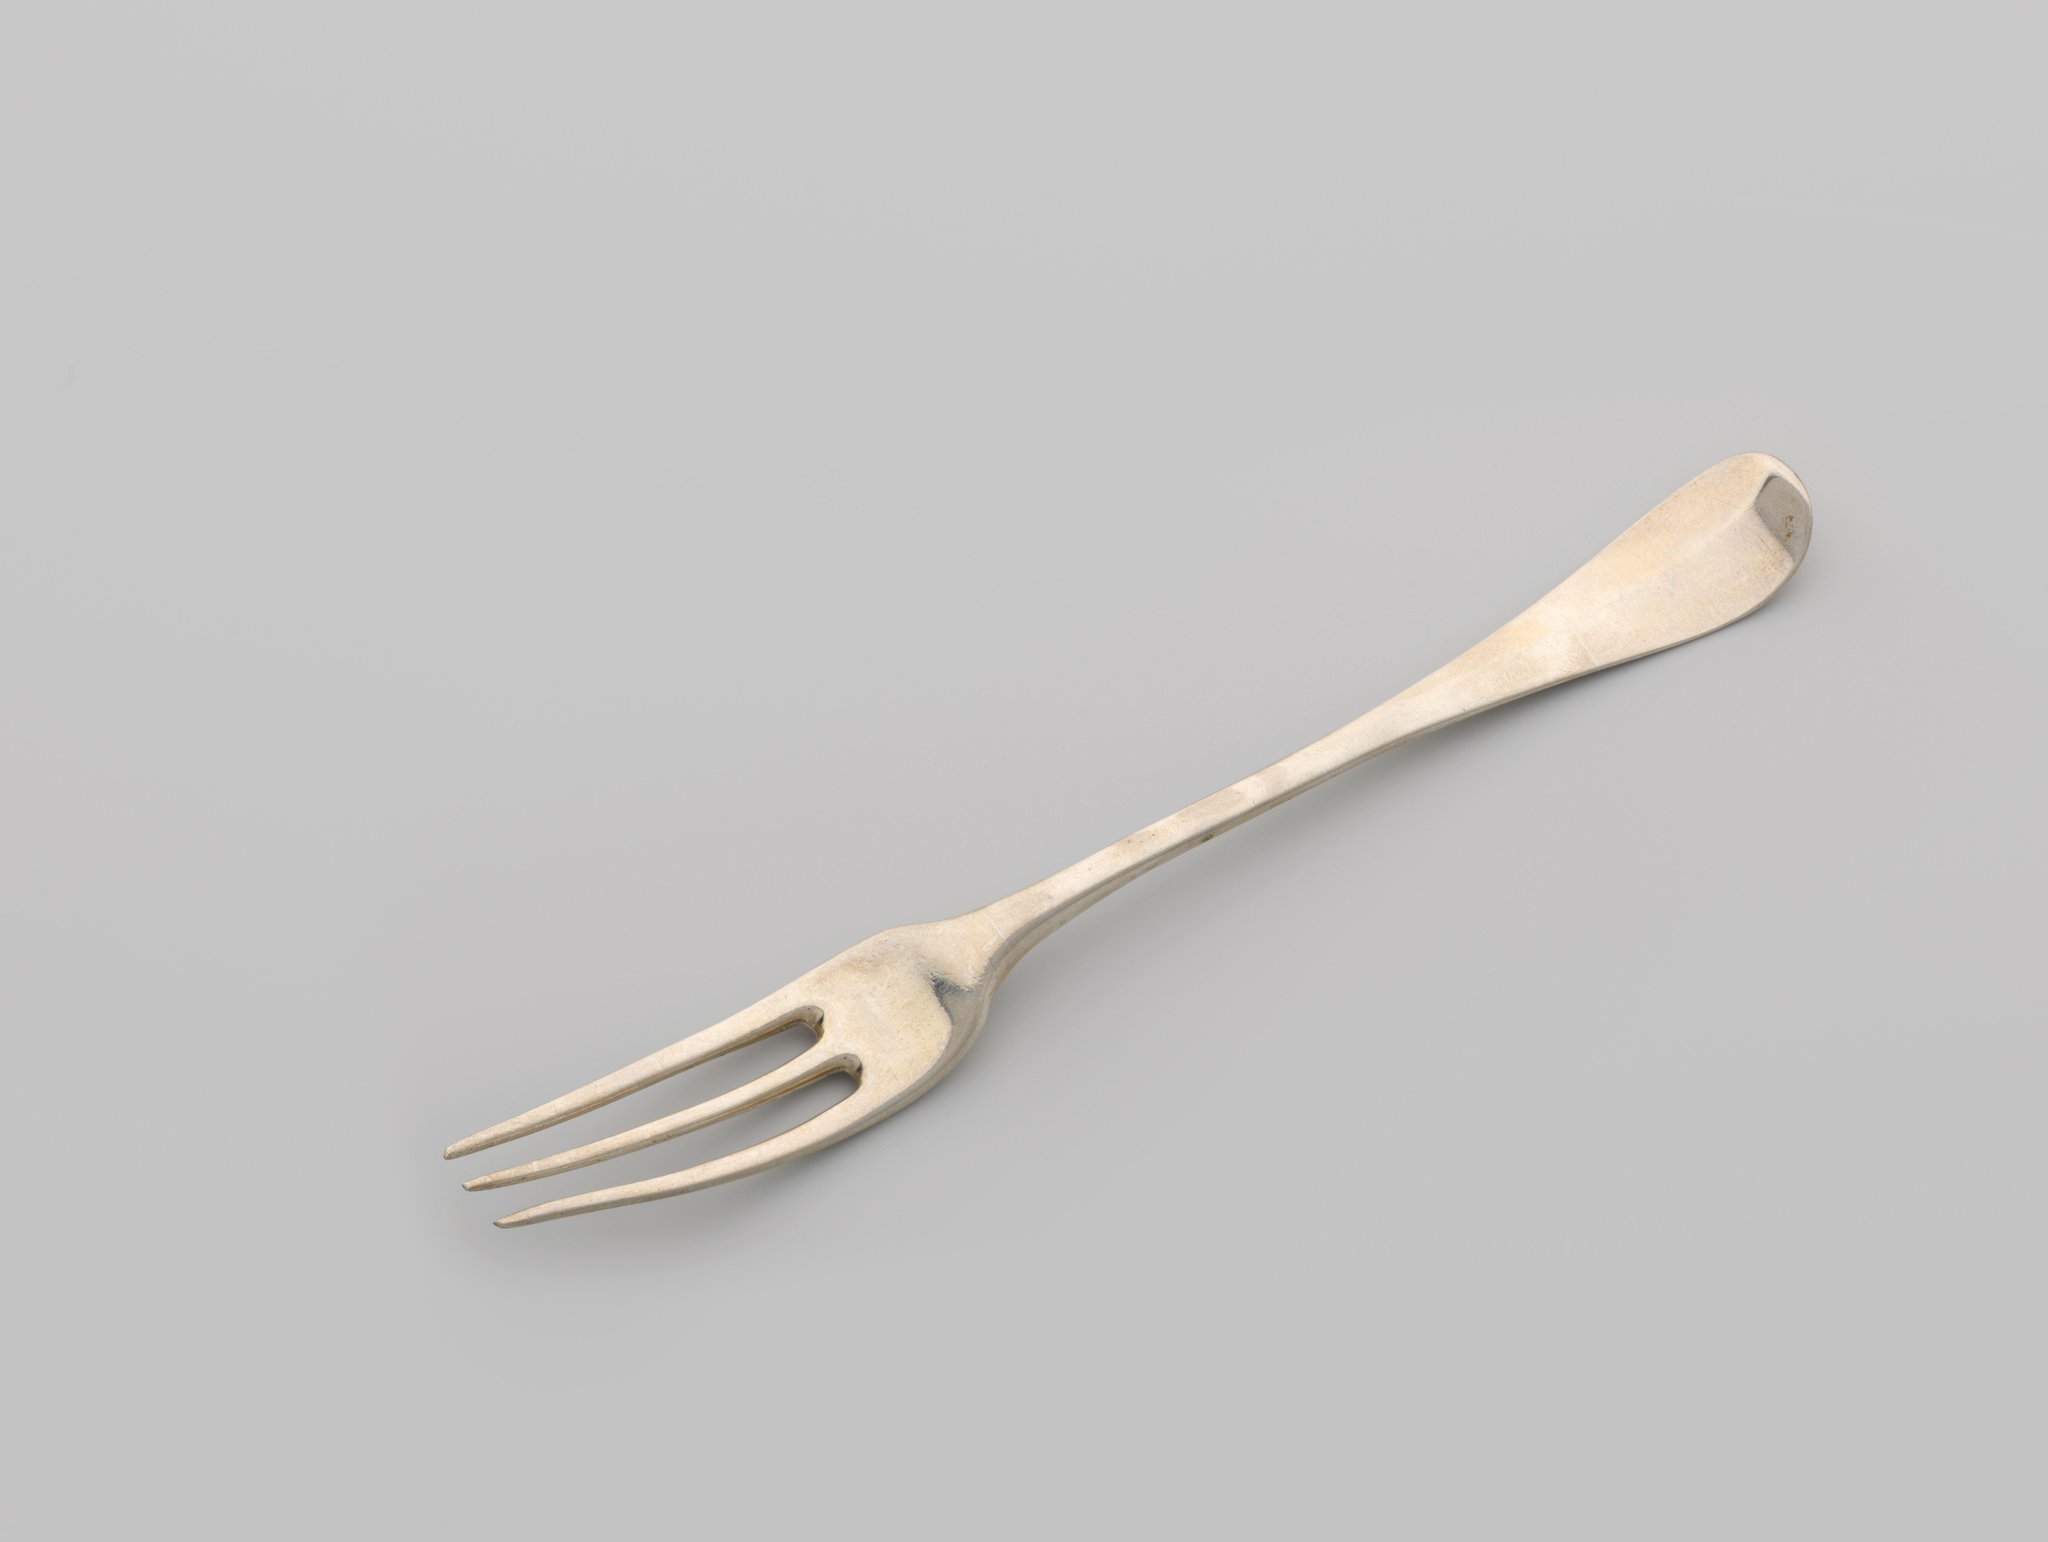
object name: fork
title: Dessertvork met het helmteken Clifford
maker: cornelis loeff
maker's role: silversmith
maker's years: 1738-1793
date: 1793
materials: silver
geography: amsterdam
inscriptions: maker's mark, town mark, date letter: ‘I’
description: De drietandige vork is door middel van enkel lof verbonden met de platte, gebogen steel, die zich verbreedt naar het afgeronde uiteinde en die aan de bovenzijde over het midden een flauwe ribbel vertoont. Op de onderzijde van de steel is het helmteken Clifford gegraveerd.